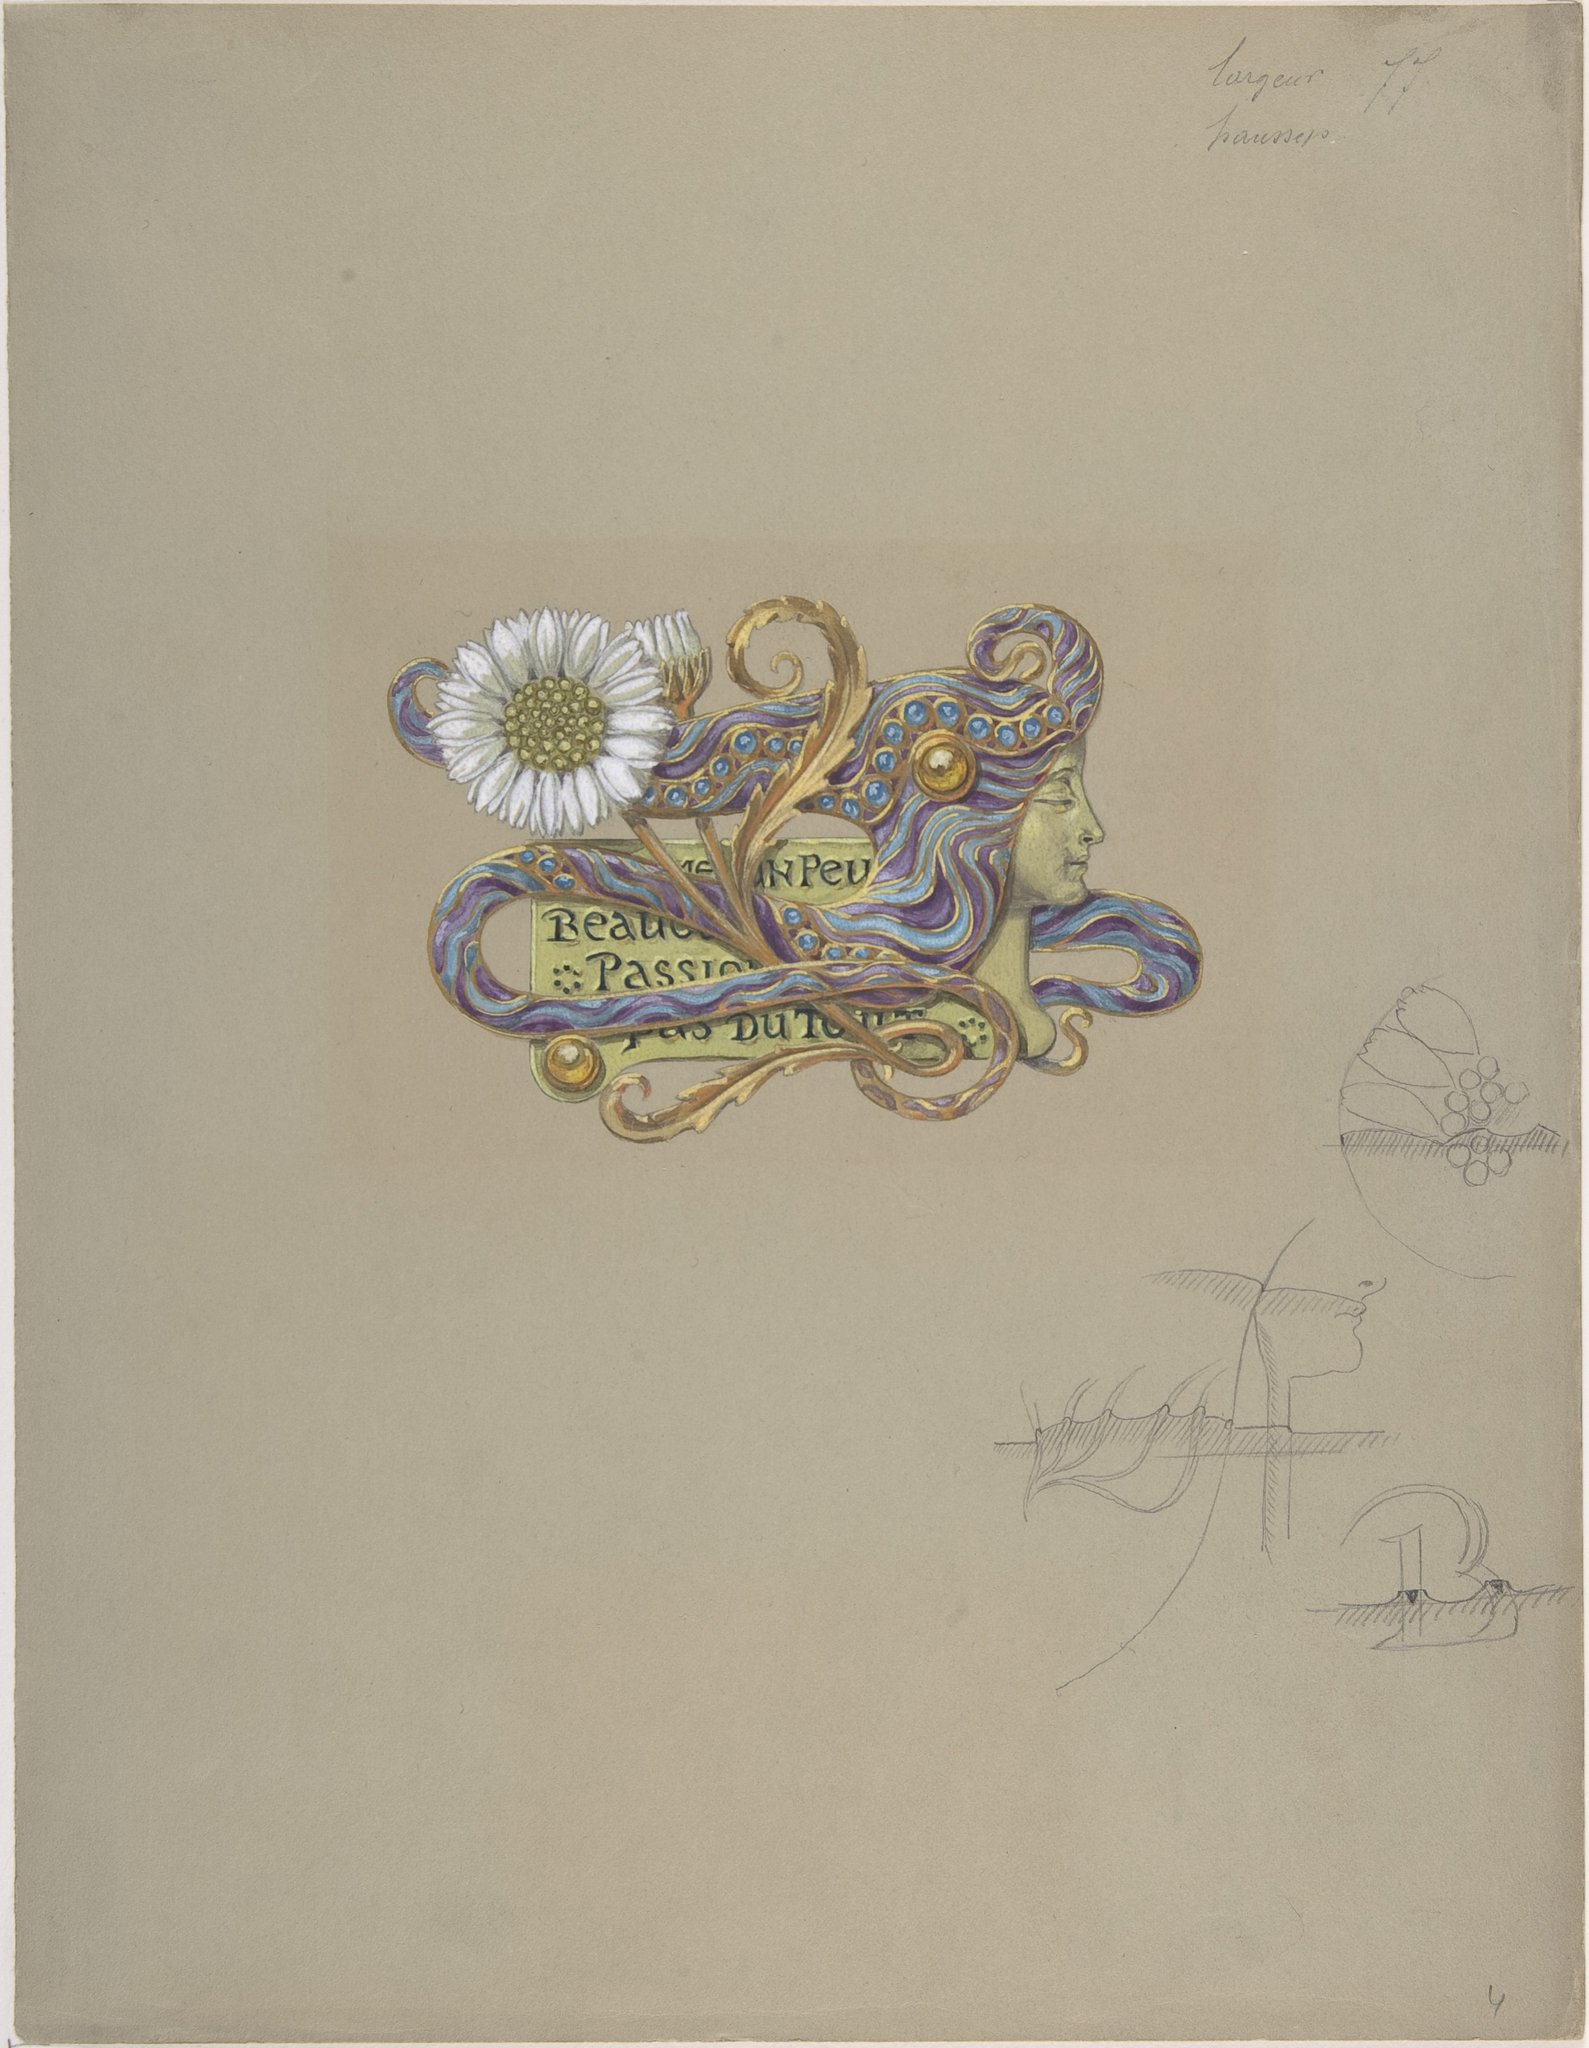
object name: drawing ornament architecture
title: Jewelry Design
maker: eugène-samuel grasset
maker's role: artist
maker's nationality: french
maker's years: 1841-1917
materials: gold, watercolor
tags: faces,heads,flowers